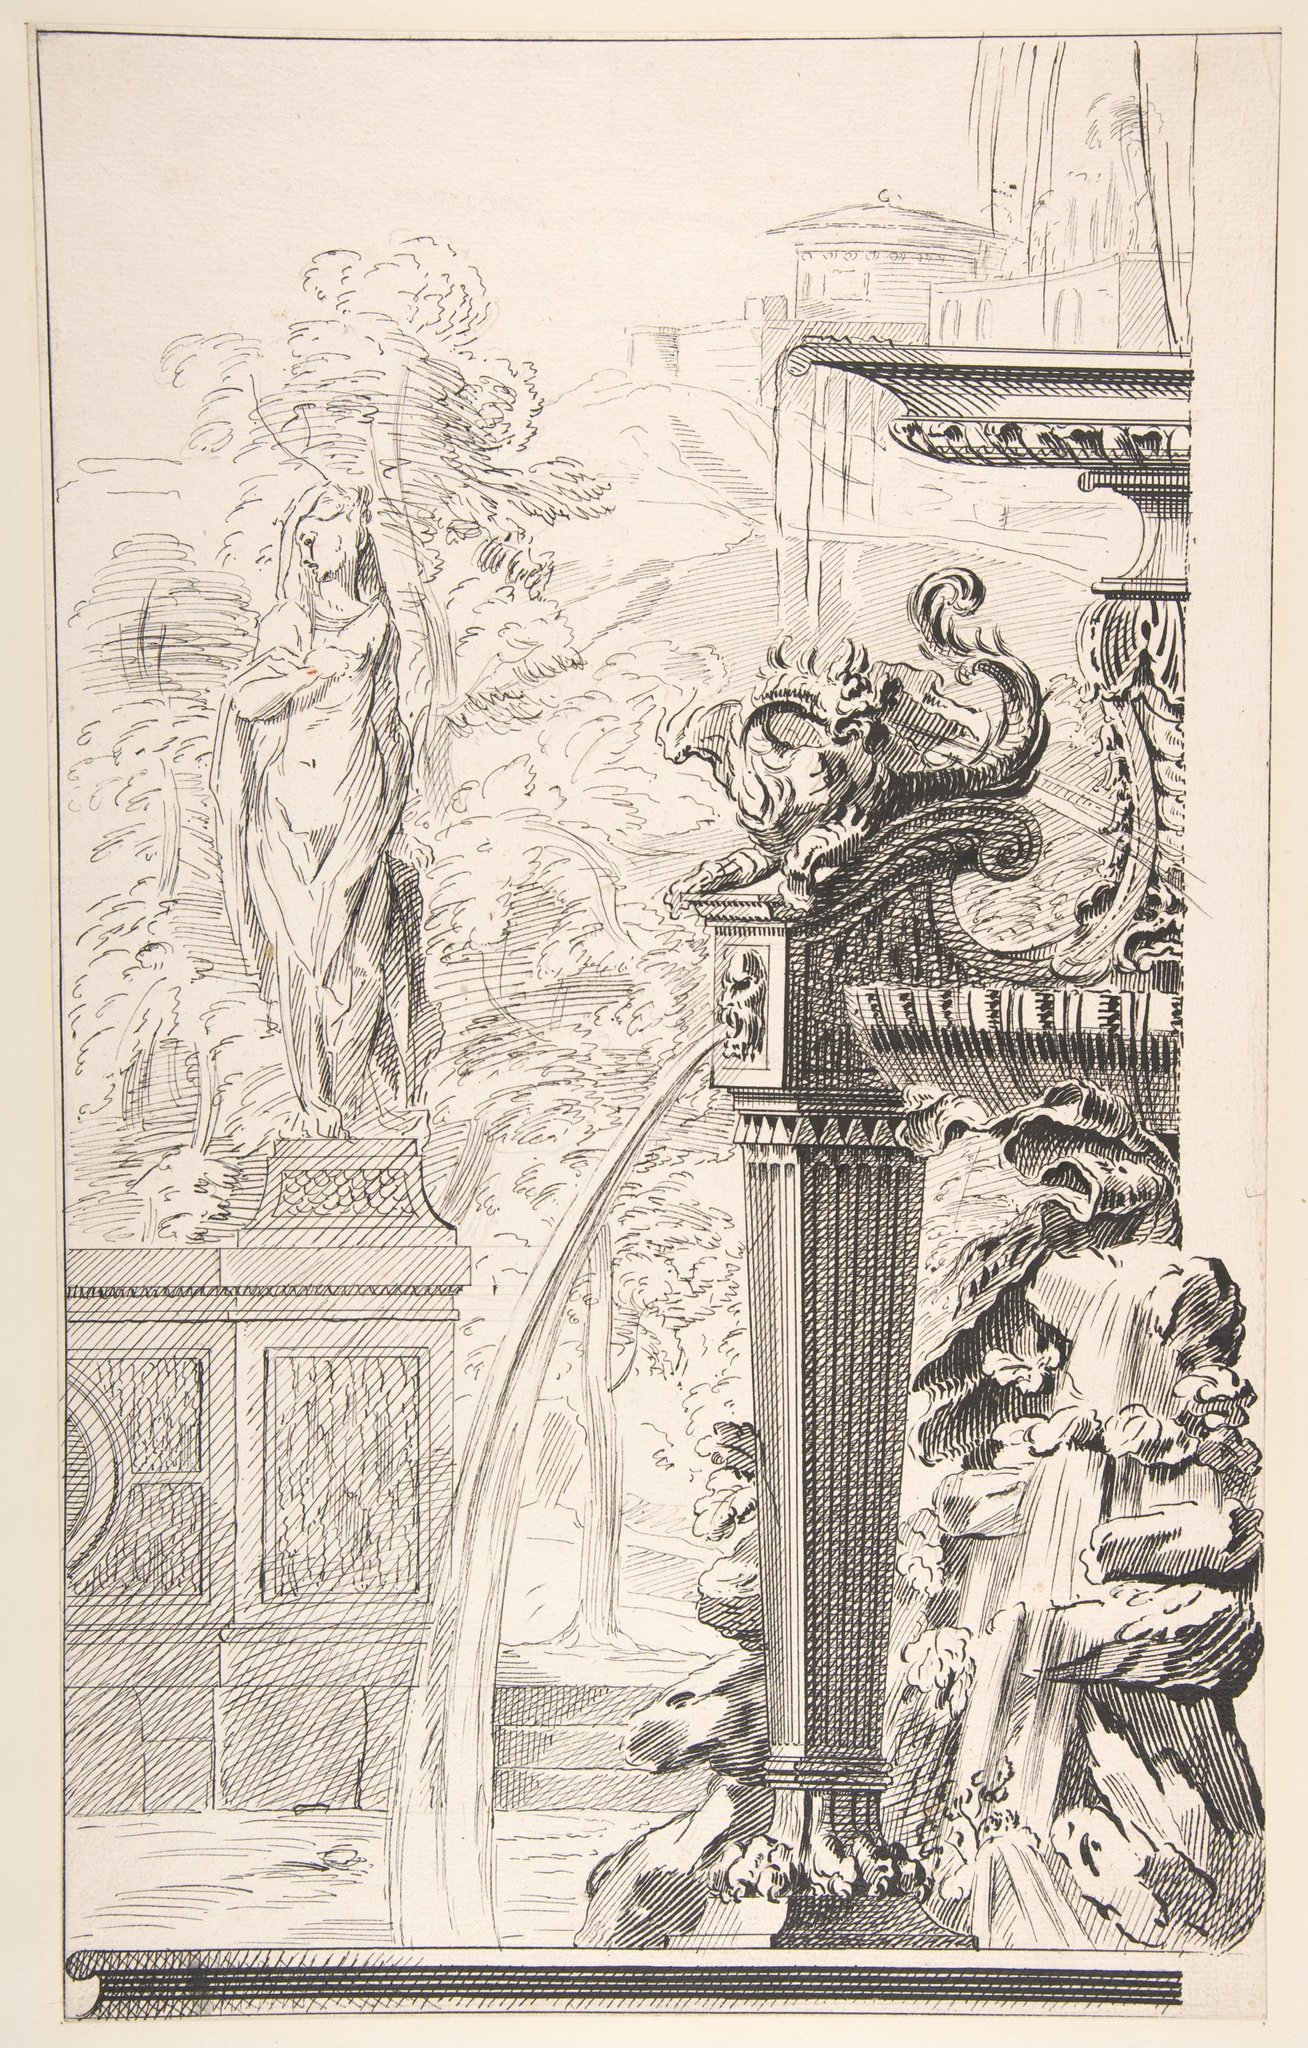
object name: drawing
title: Study for a Garden Capriccio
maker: gilles-marie oppenord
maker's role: artist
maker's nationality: french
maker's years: 1672-1742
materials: graphite, ink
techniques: pen, drawing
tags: fountains,gardens